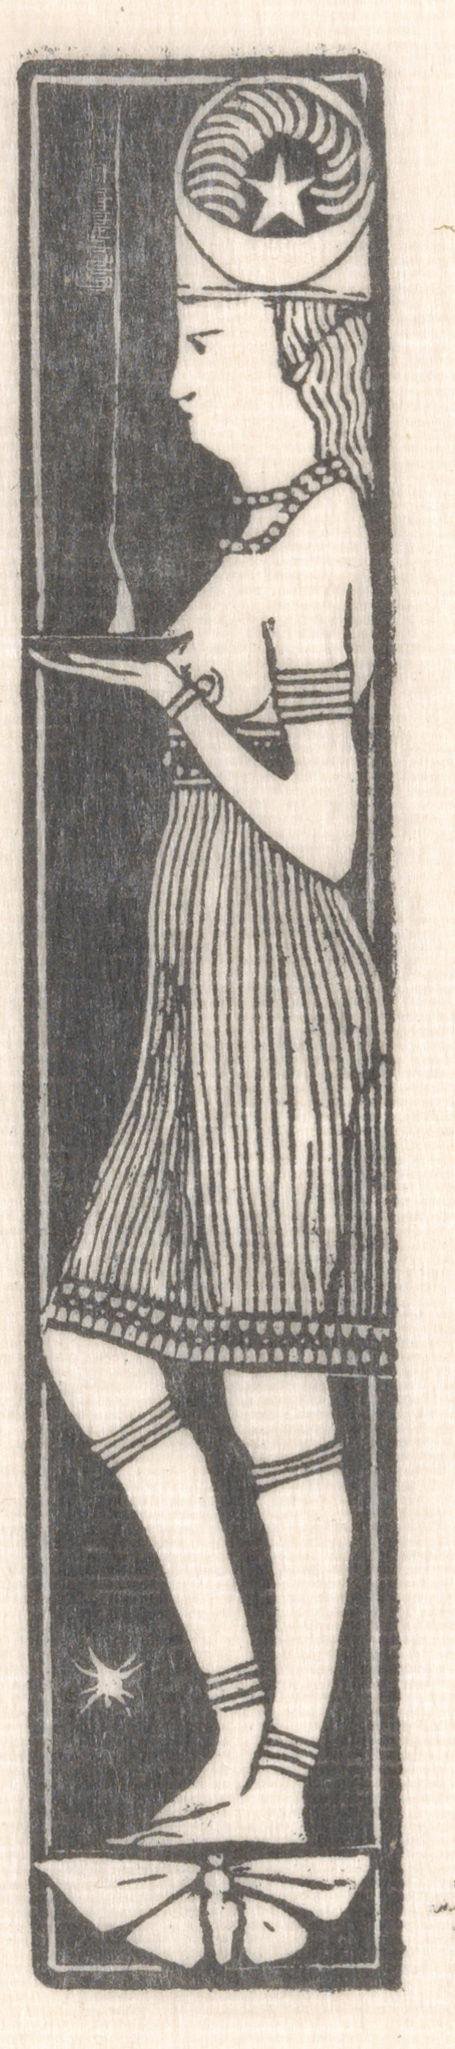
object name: print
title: Staande vrouw met lamp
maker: mathieu lauweriks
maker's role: designer, draughtsman, print maker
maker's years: 1864-1932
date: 1895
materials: paper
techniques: woodcut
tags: oil-lamp, standing figure - aa - female human figure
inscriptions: collector's mark: Lugt 2228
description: Prent mogelijk gebruikt als illustratie van het gedicht 'Kama' in: Licht en waarheid. Orgaan van de vereeniging 'Wie Denkt Overwint'. Amsterdam: Wie Denkt Overwint, 31 augustus 1895.